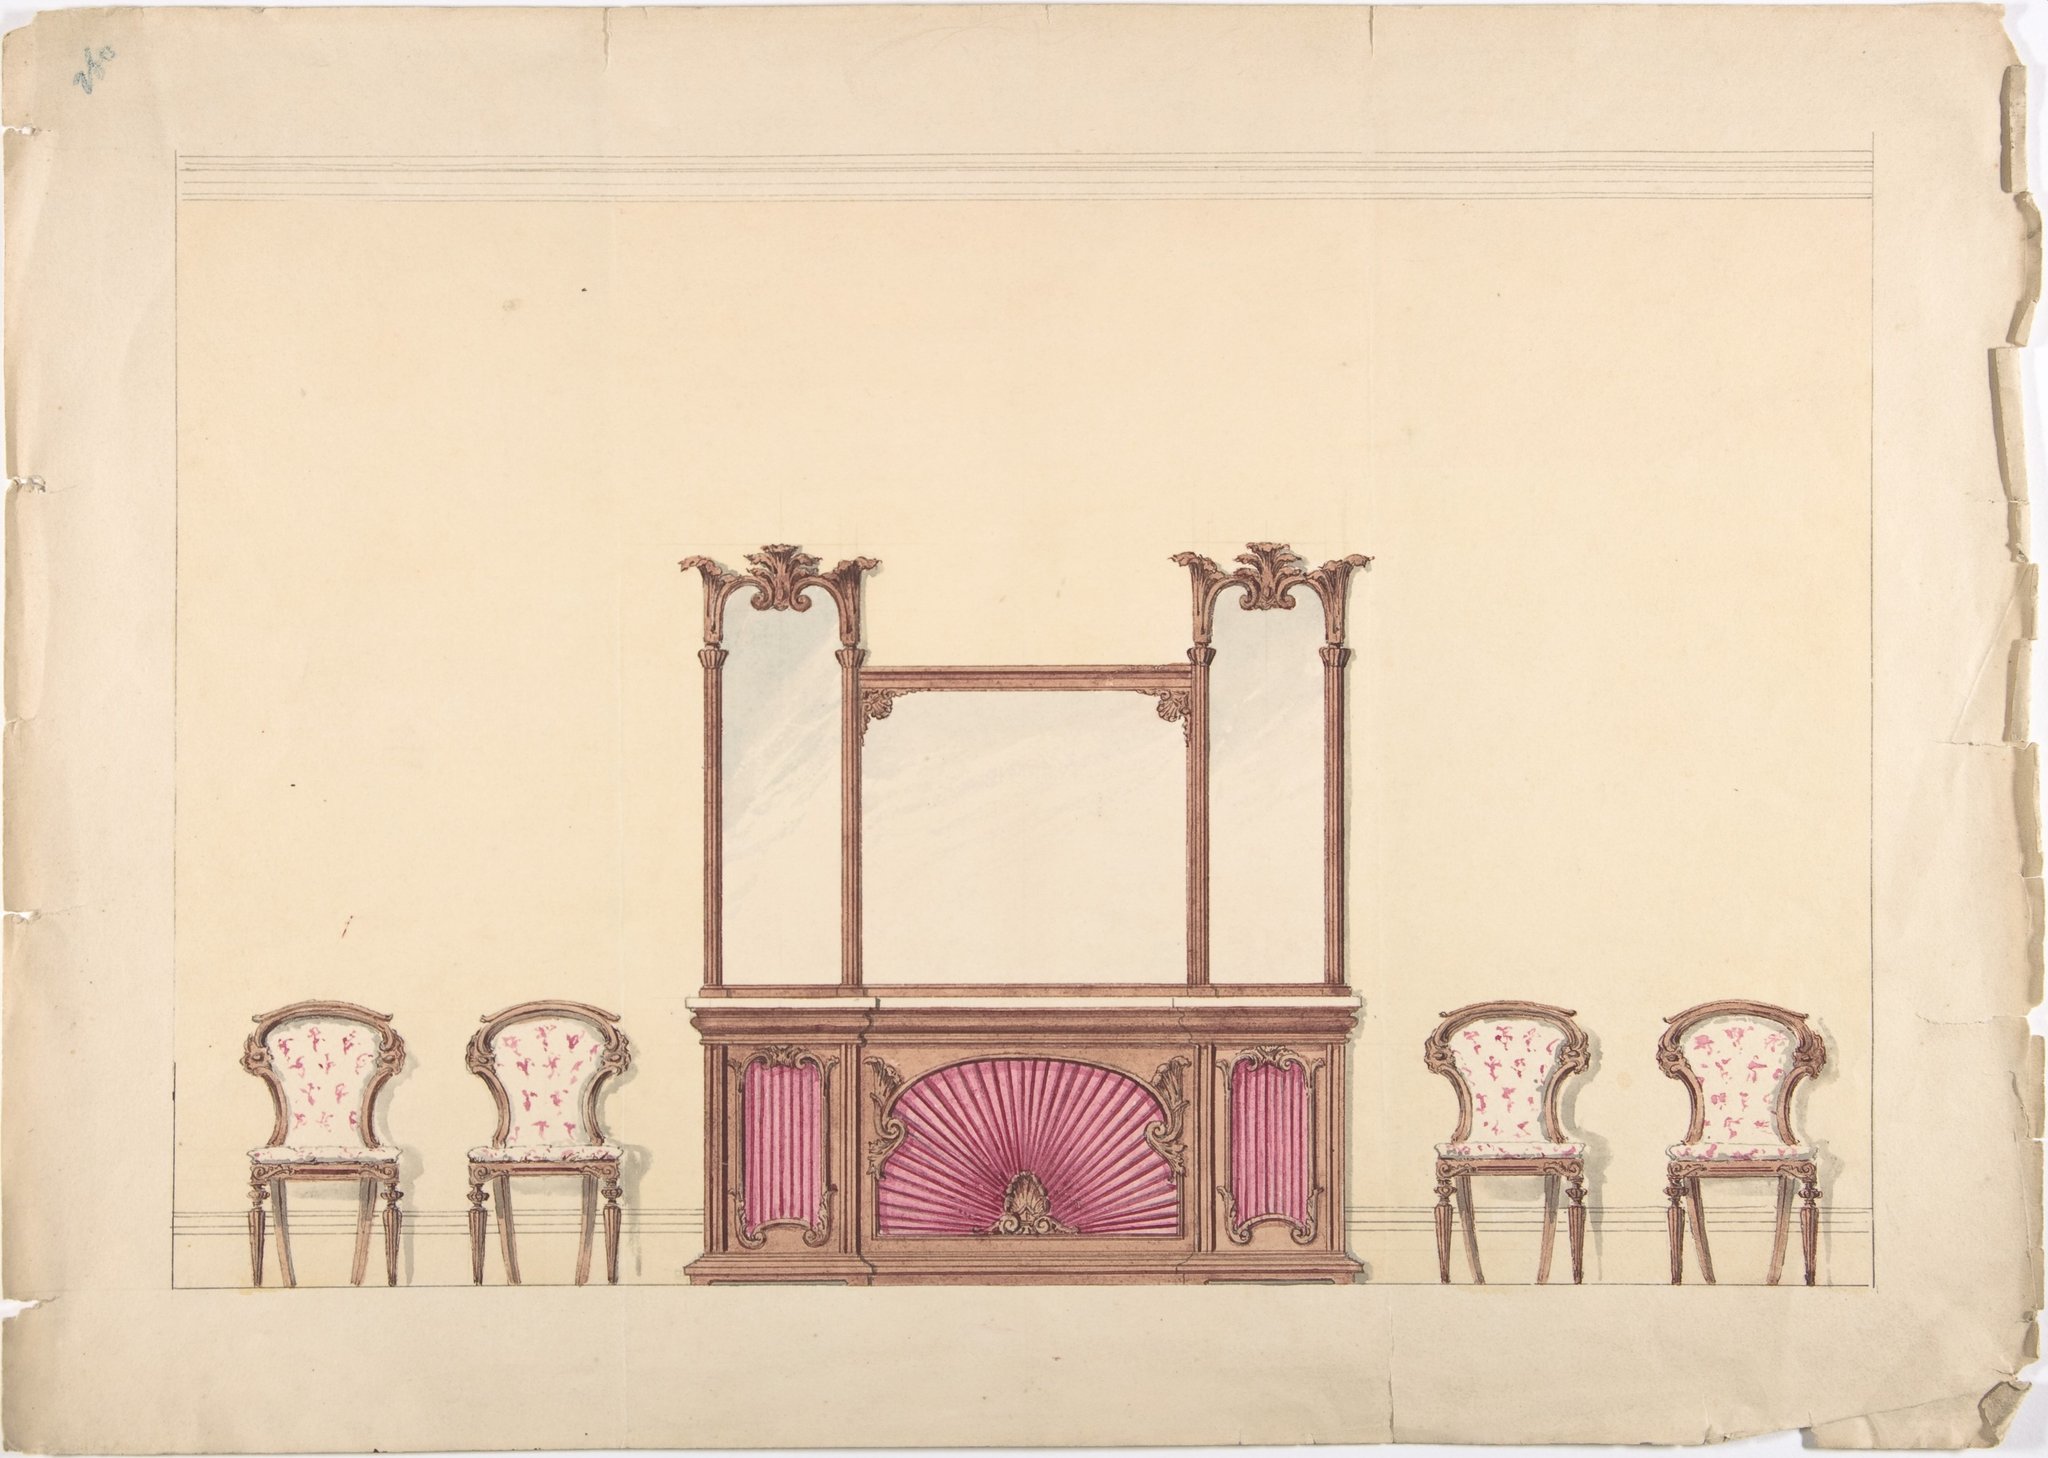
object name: drawing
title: Design for a Mirrored Cabinet and Four Chairs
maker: anonymous, british, 19th century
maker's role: artist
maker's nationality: british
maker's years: 1800-1900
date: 1801-1833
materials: ink, watercolor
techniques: brush, pen, wash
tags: chairs,cabinets,mirrors